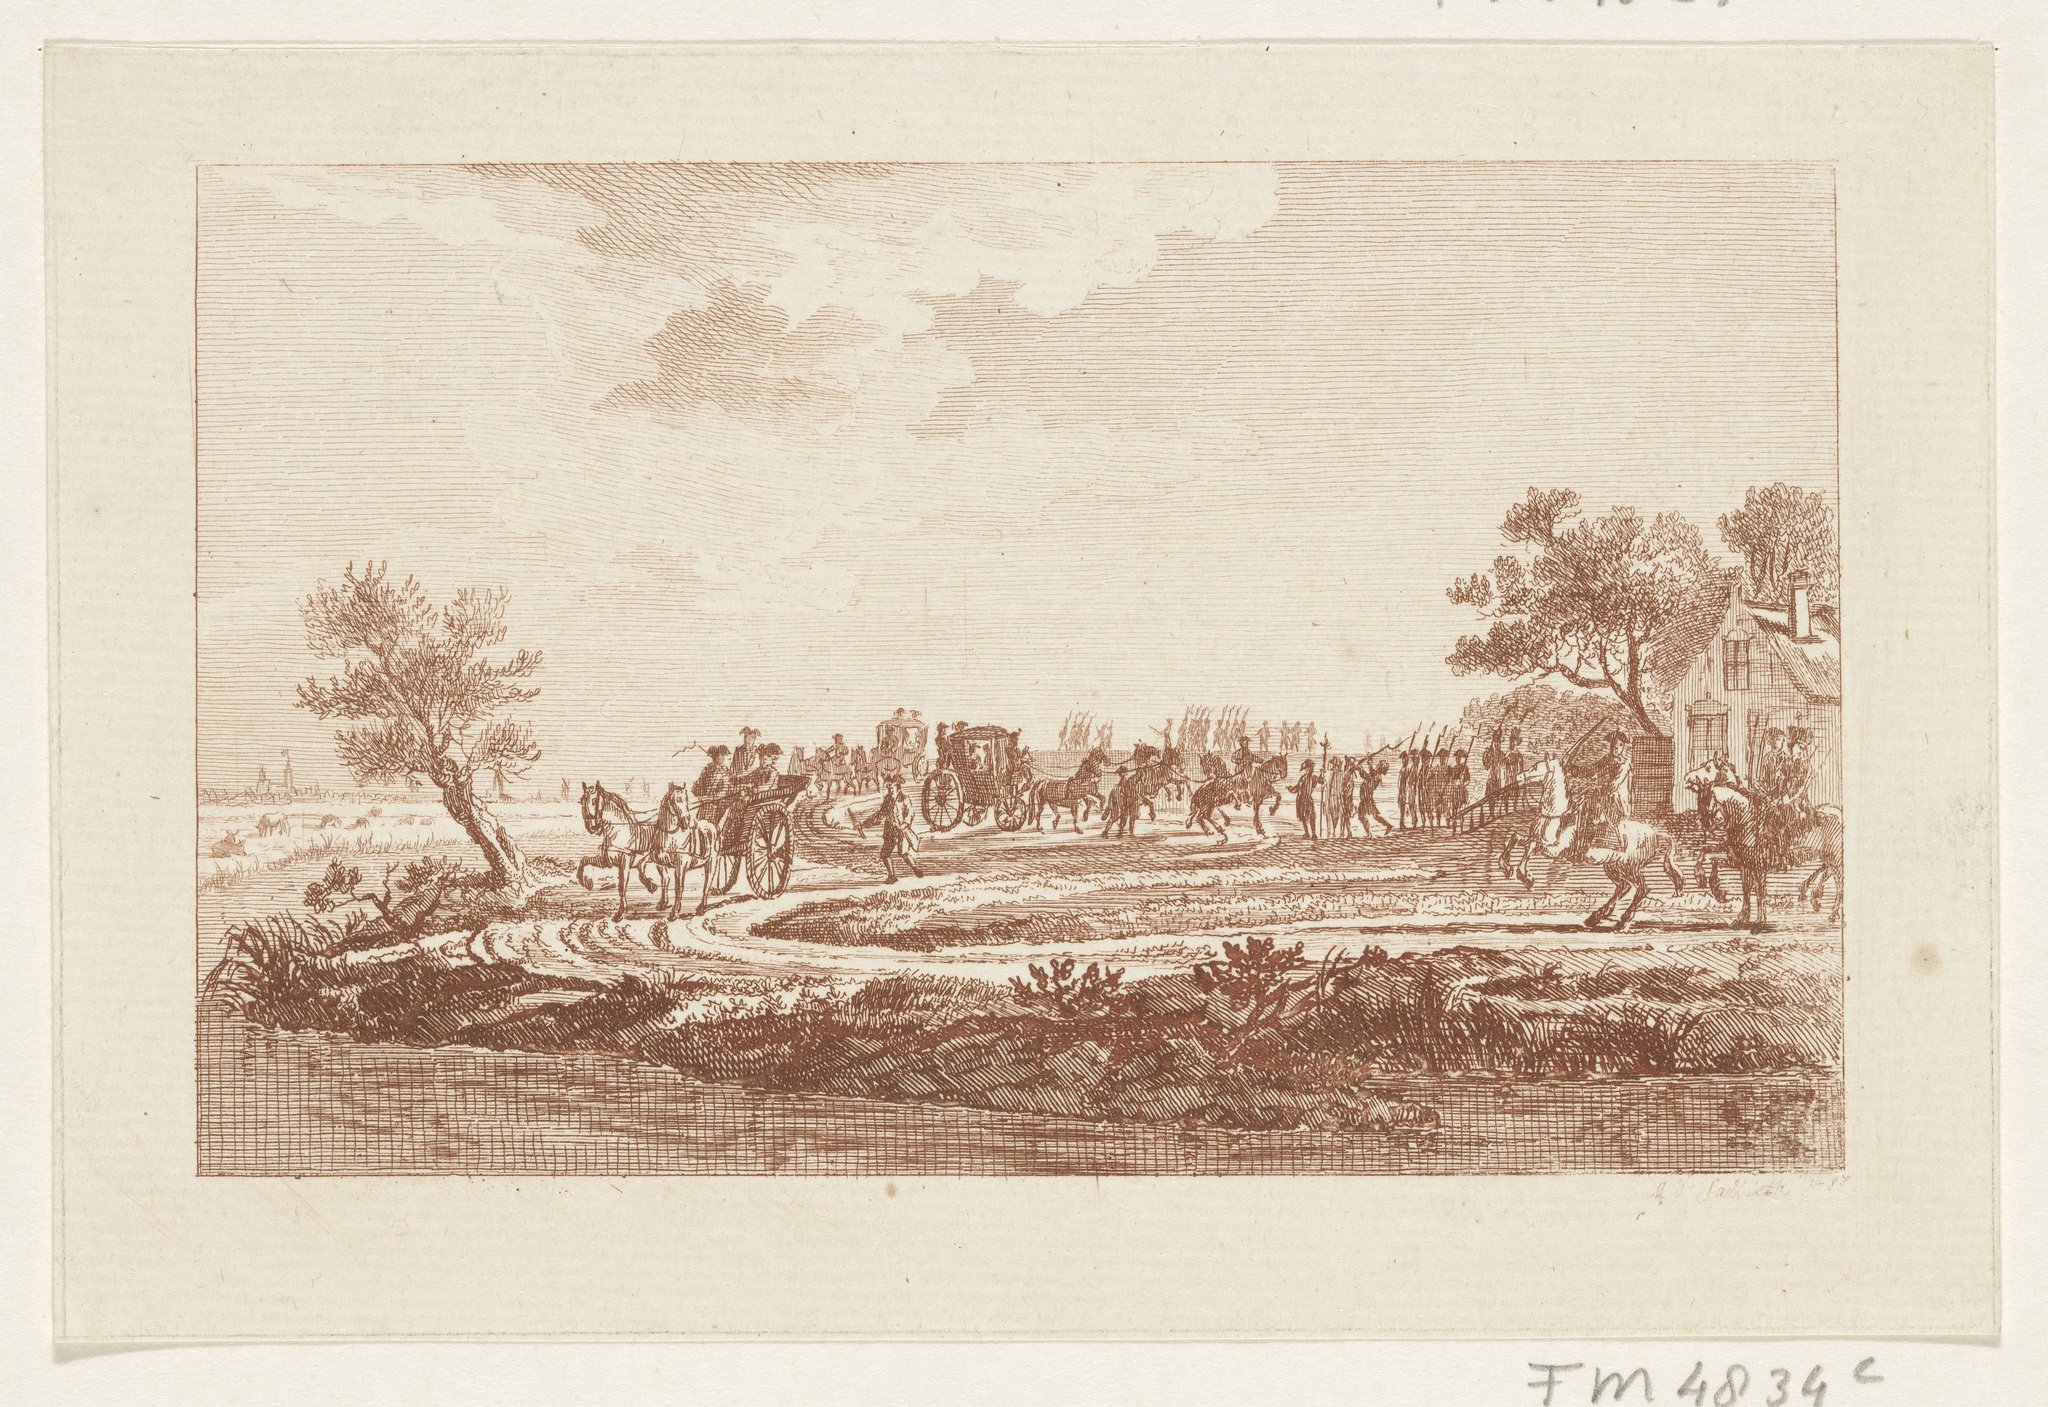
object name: print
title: Aanhouding van de prinses bij Goejanverwellesluis, 178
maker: mathias de sallieth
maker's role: print maker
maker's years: 1749-1791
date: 1787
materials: paper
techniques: engraving, etching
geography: northern netherlands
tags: berlin, painter, draughtsman, wilhelmina of prussia (princess of orange), arrest (of criminal)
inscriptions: collector's mark: Lugt 2228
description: Gebruikt als illustratie in: De Haagsche princelyke en koninglyke almanach, voor het schrikkeljaar 1788. 's-Gravenhage: Johannes François Jacobs d'Agé, 1788.